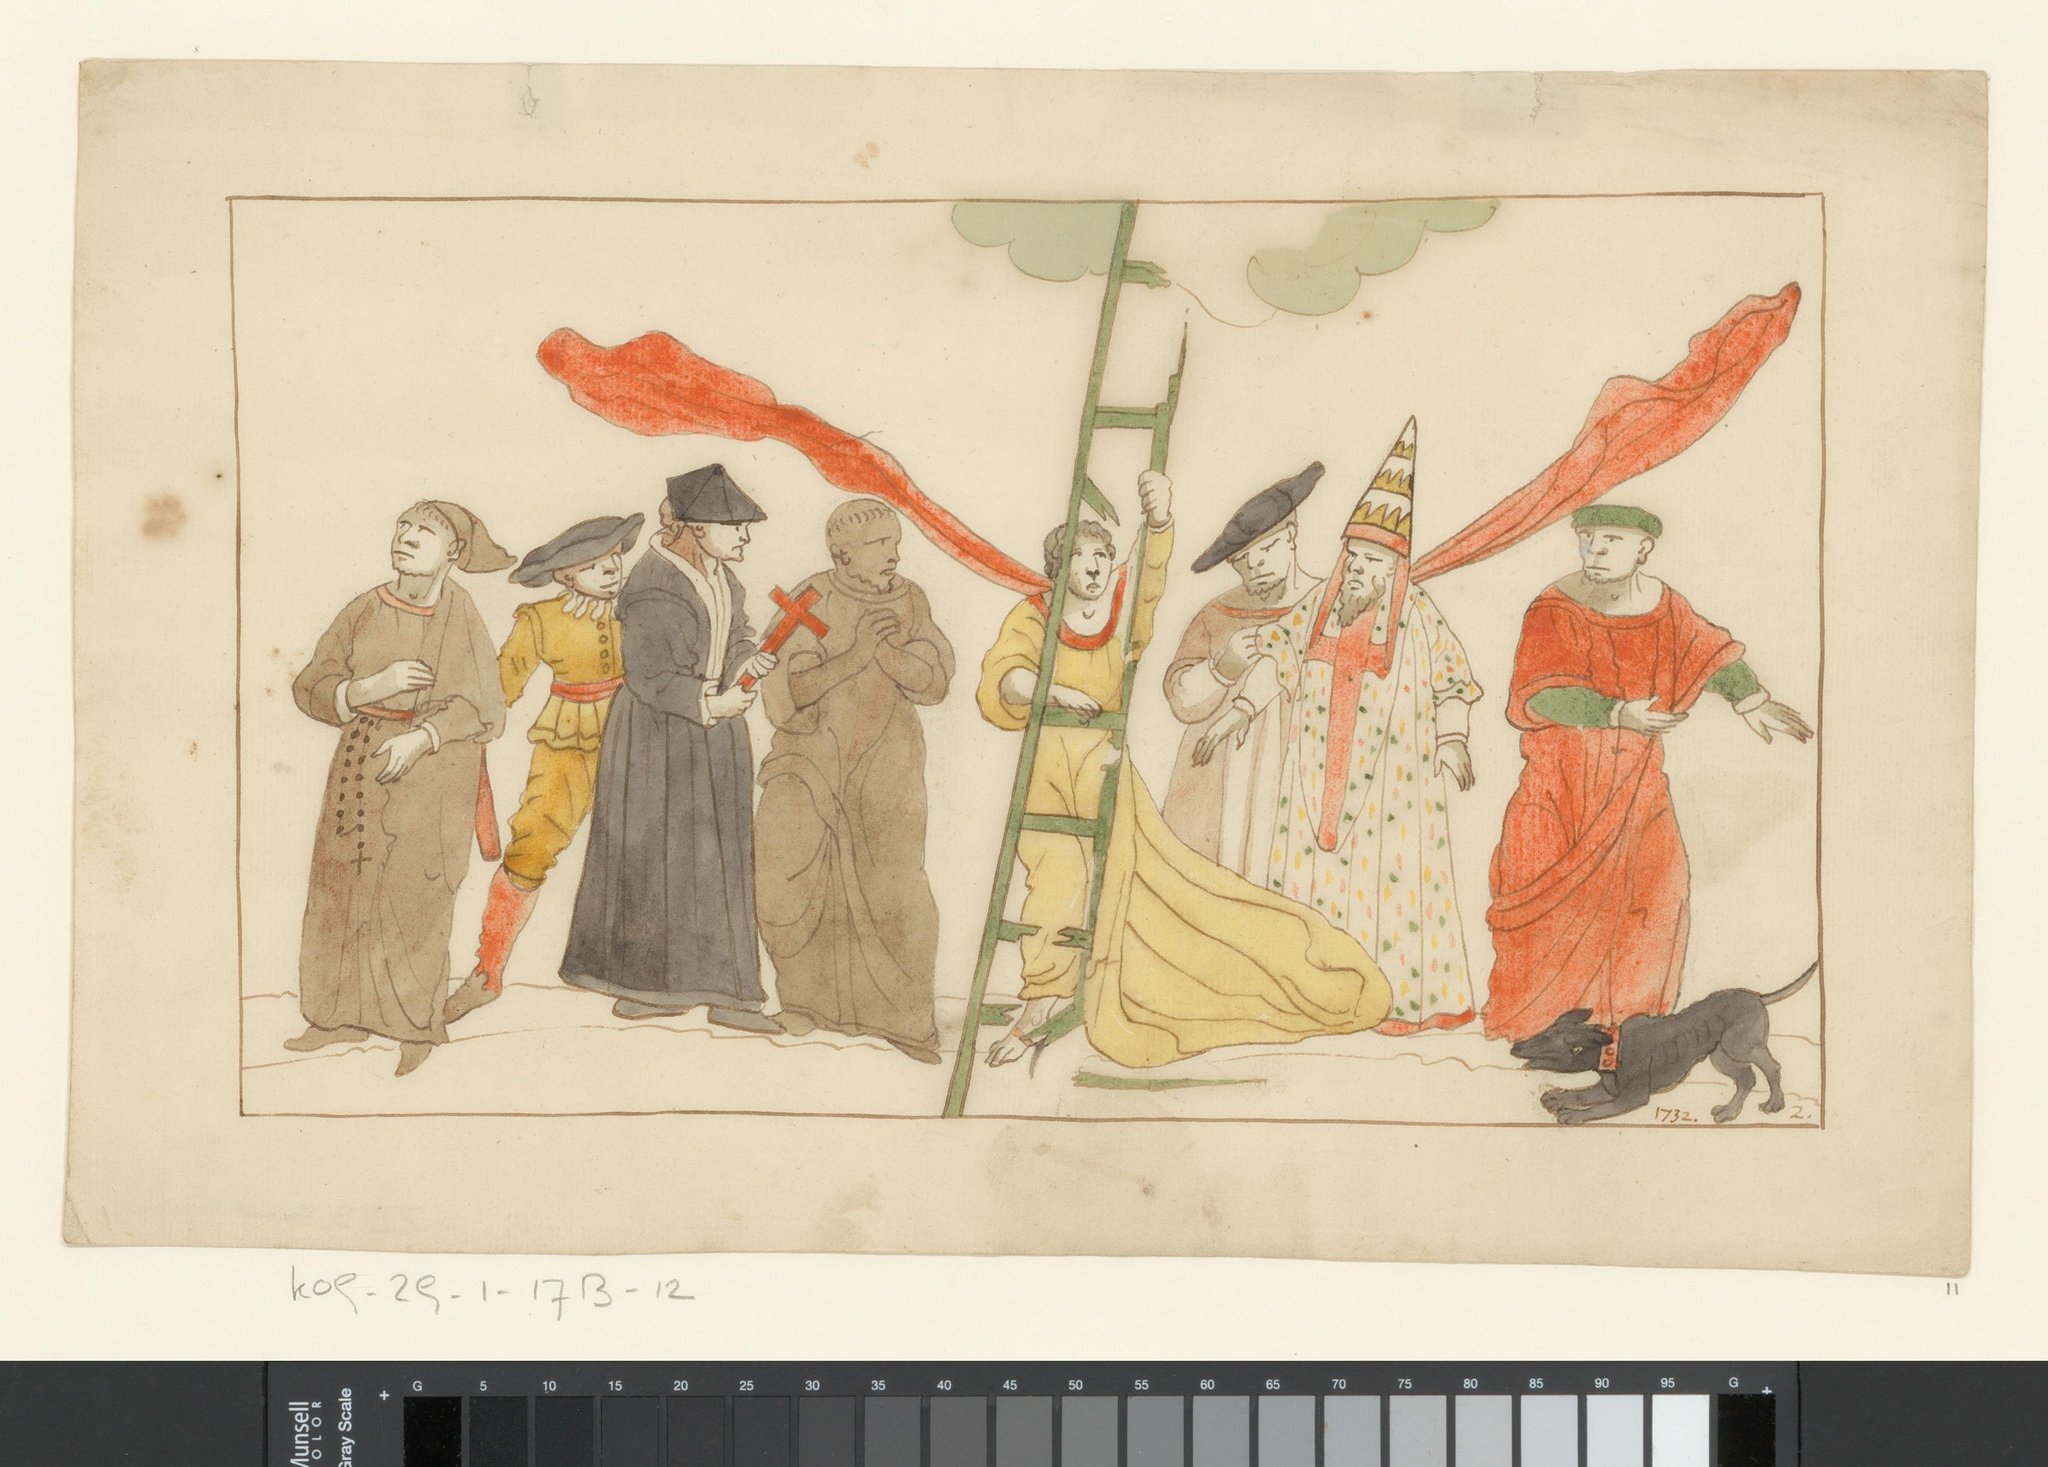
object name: drawing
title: Leerkomedie in Brabant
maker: Anonymous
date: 1800-1847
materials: ink, paper, watercolor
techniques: brush, pen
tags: female angels, theatre, theatrical performance, chamber of rhetoric (dutch: 'rederijkerskamer'), ladder, pope, ladder, stairway to heaven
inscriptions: collector's mark: Lugt 1641, stamp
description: Vrouw probeert een kapotte ladder te beklimmen die naar de hemel leidt. Bij haar staan de paus en andere geestelijken. Onderwerpsrubrieken binnen de Atlas Zeden en Gewoonten: Schoone kunsten, Tooneel, Rederijkers.